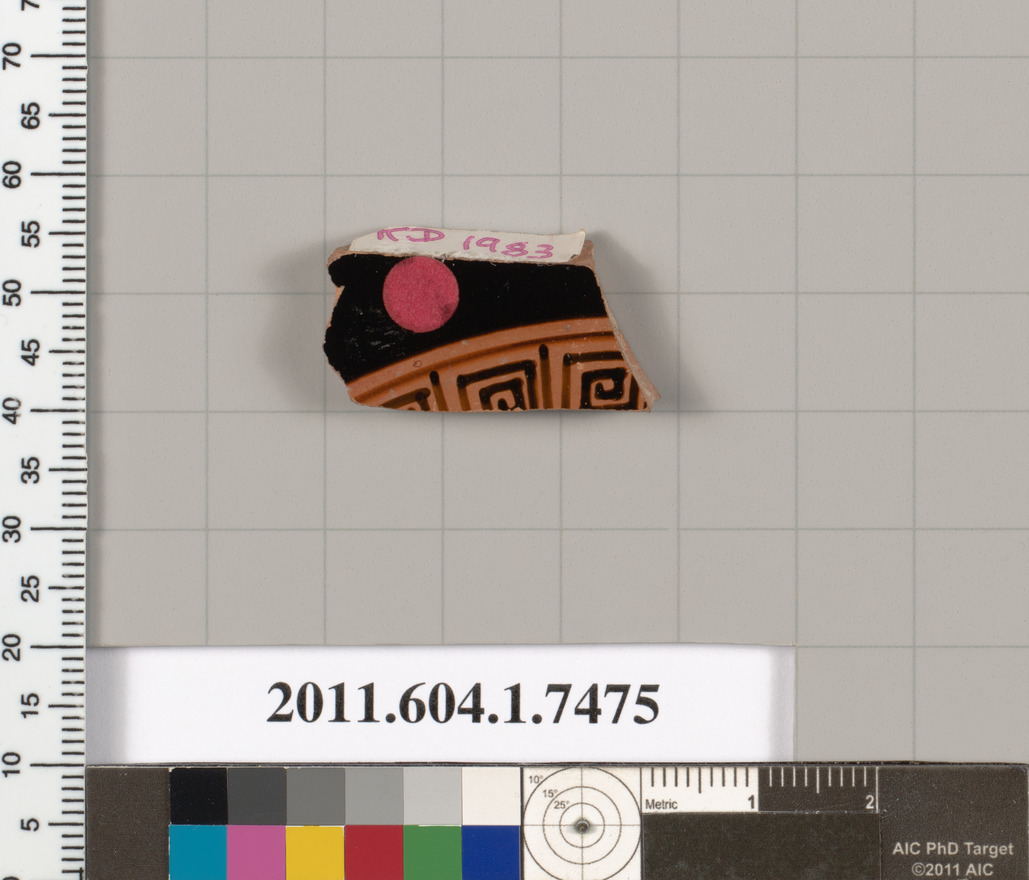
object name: kylix fragment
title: Terracotta fragment of a kylix (drinking cup)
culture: greek, attic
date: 470-460 BCE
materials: terracotta